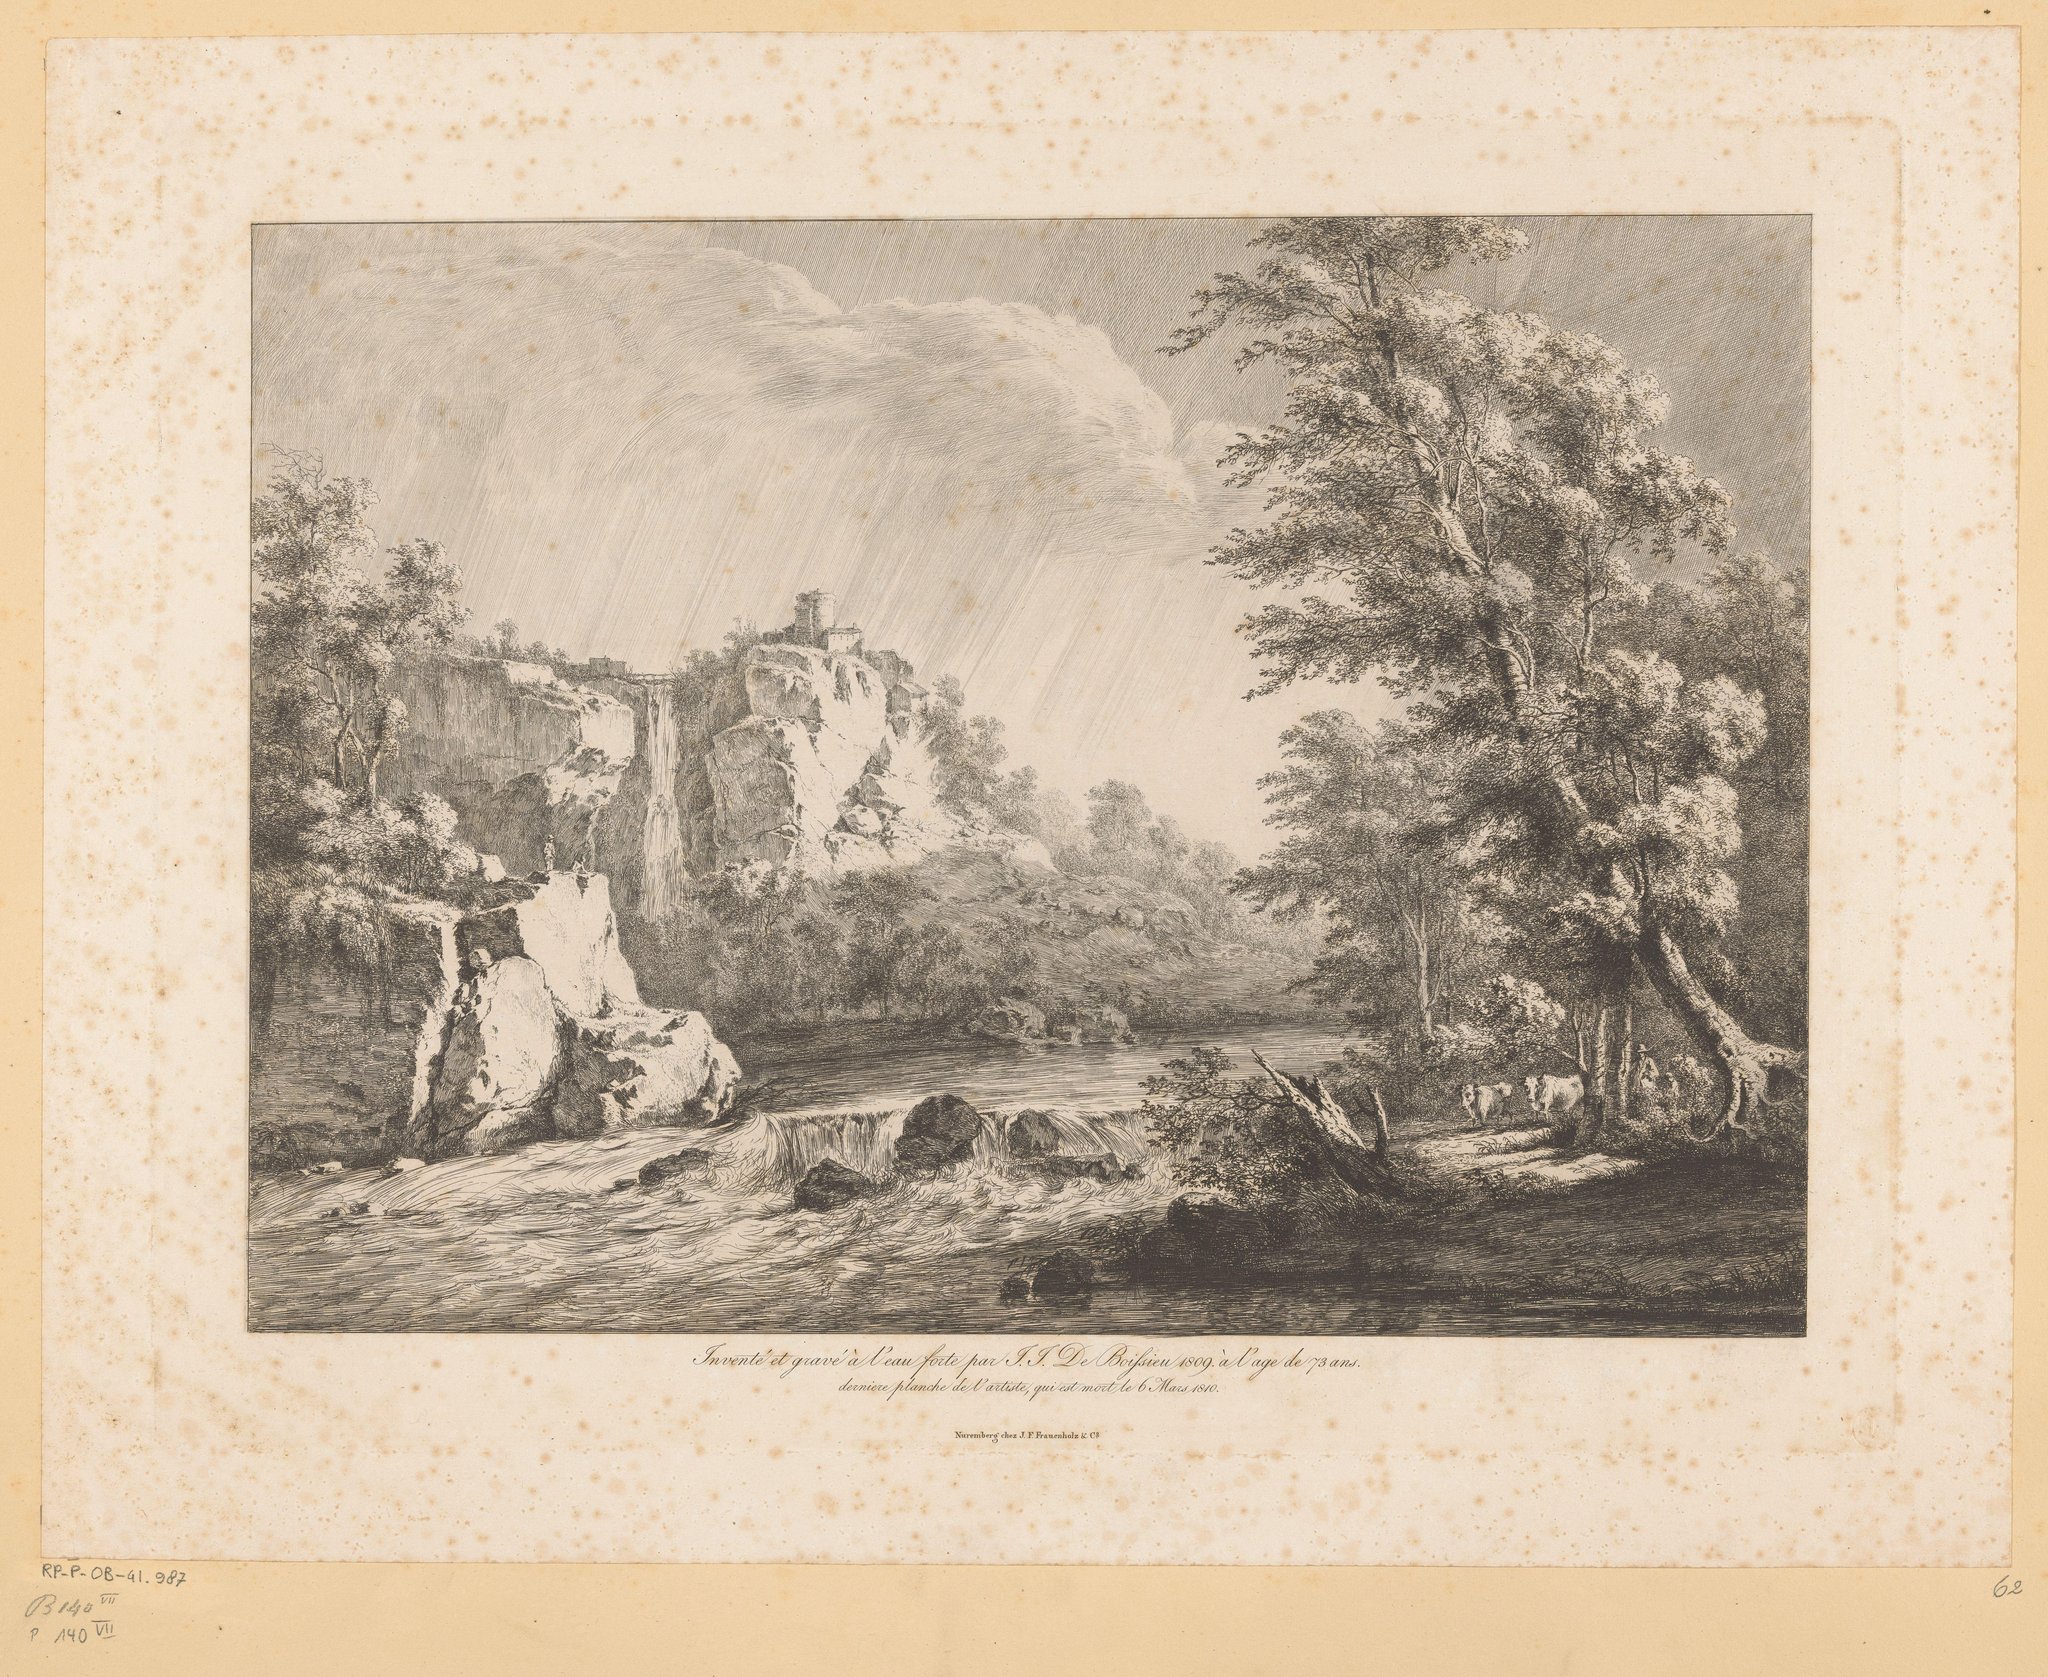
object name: print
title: Rivierlandschap met een herder bij een ontwortelde berk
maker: jean jacques de boissieu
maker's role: draughtsman, print maker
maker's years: 1736-1810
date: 1809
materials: paper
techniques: drypoint, etching, roulette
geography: france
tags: herding, herdsman, herdswoman, shepherd, shepherdess, cowherd, etc., waterfall, landscapes with waters, waterscapes, seascapes (in the temperate zone), storm, trees: birch, herd, flock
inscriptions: collector's mark: Lugt 994, collector's mark: Lugt 12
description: Volgens het opschrift betreft dit de laatste prent van Boissieu's hand.